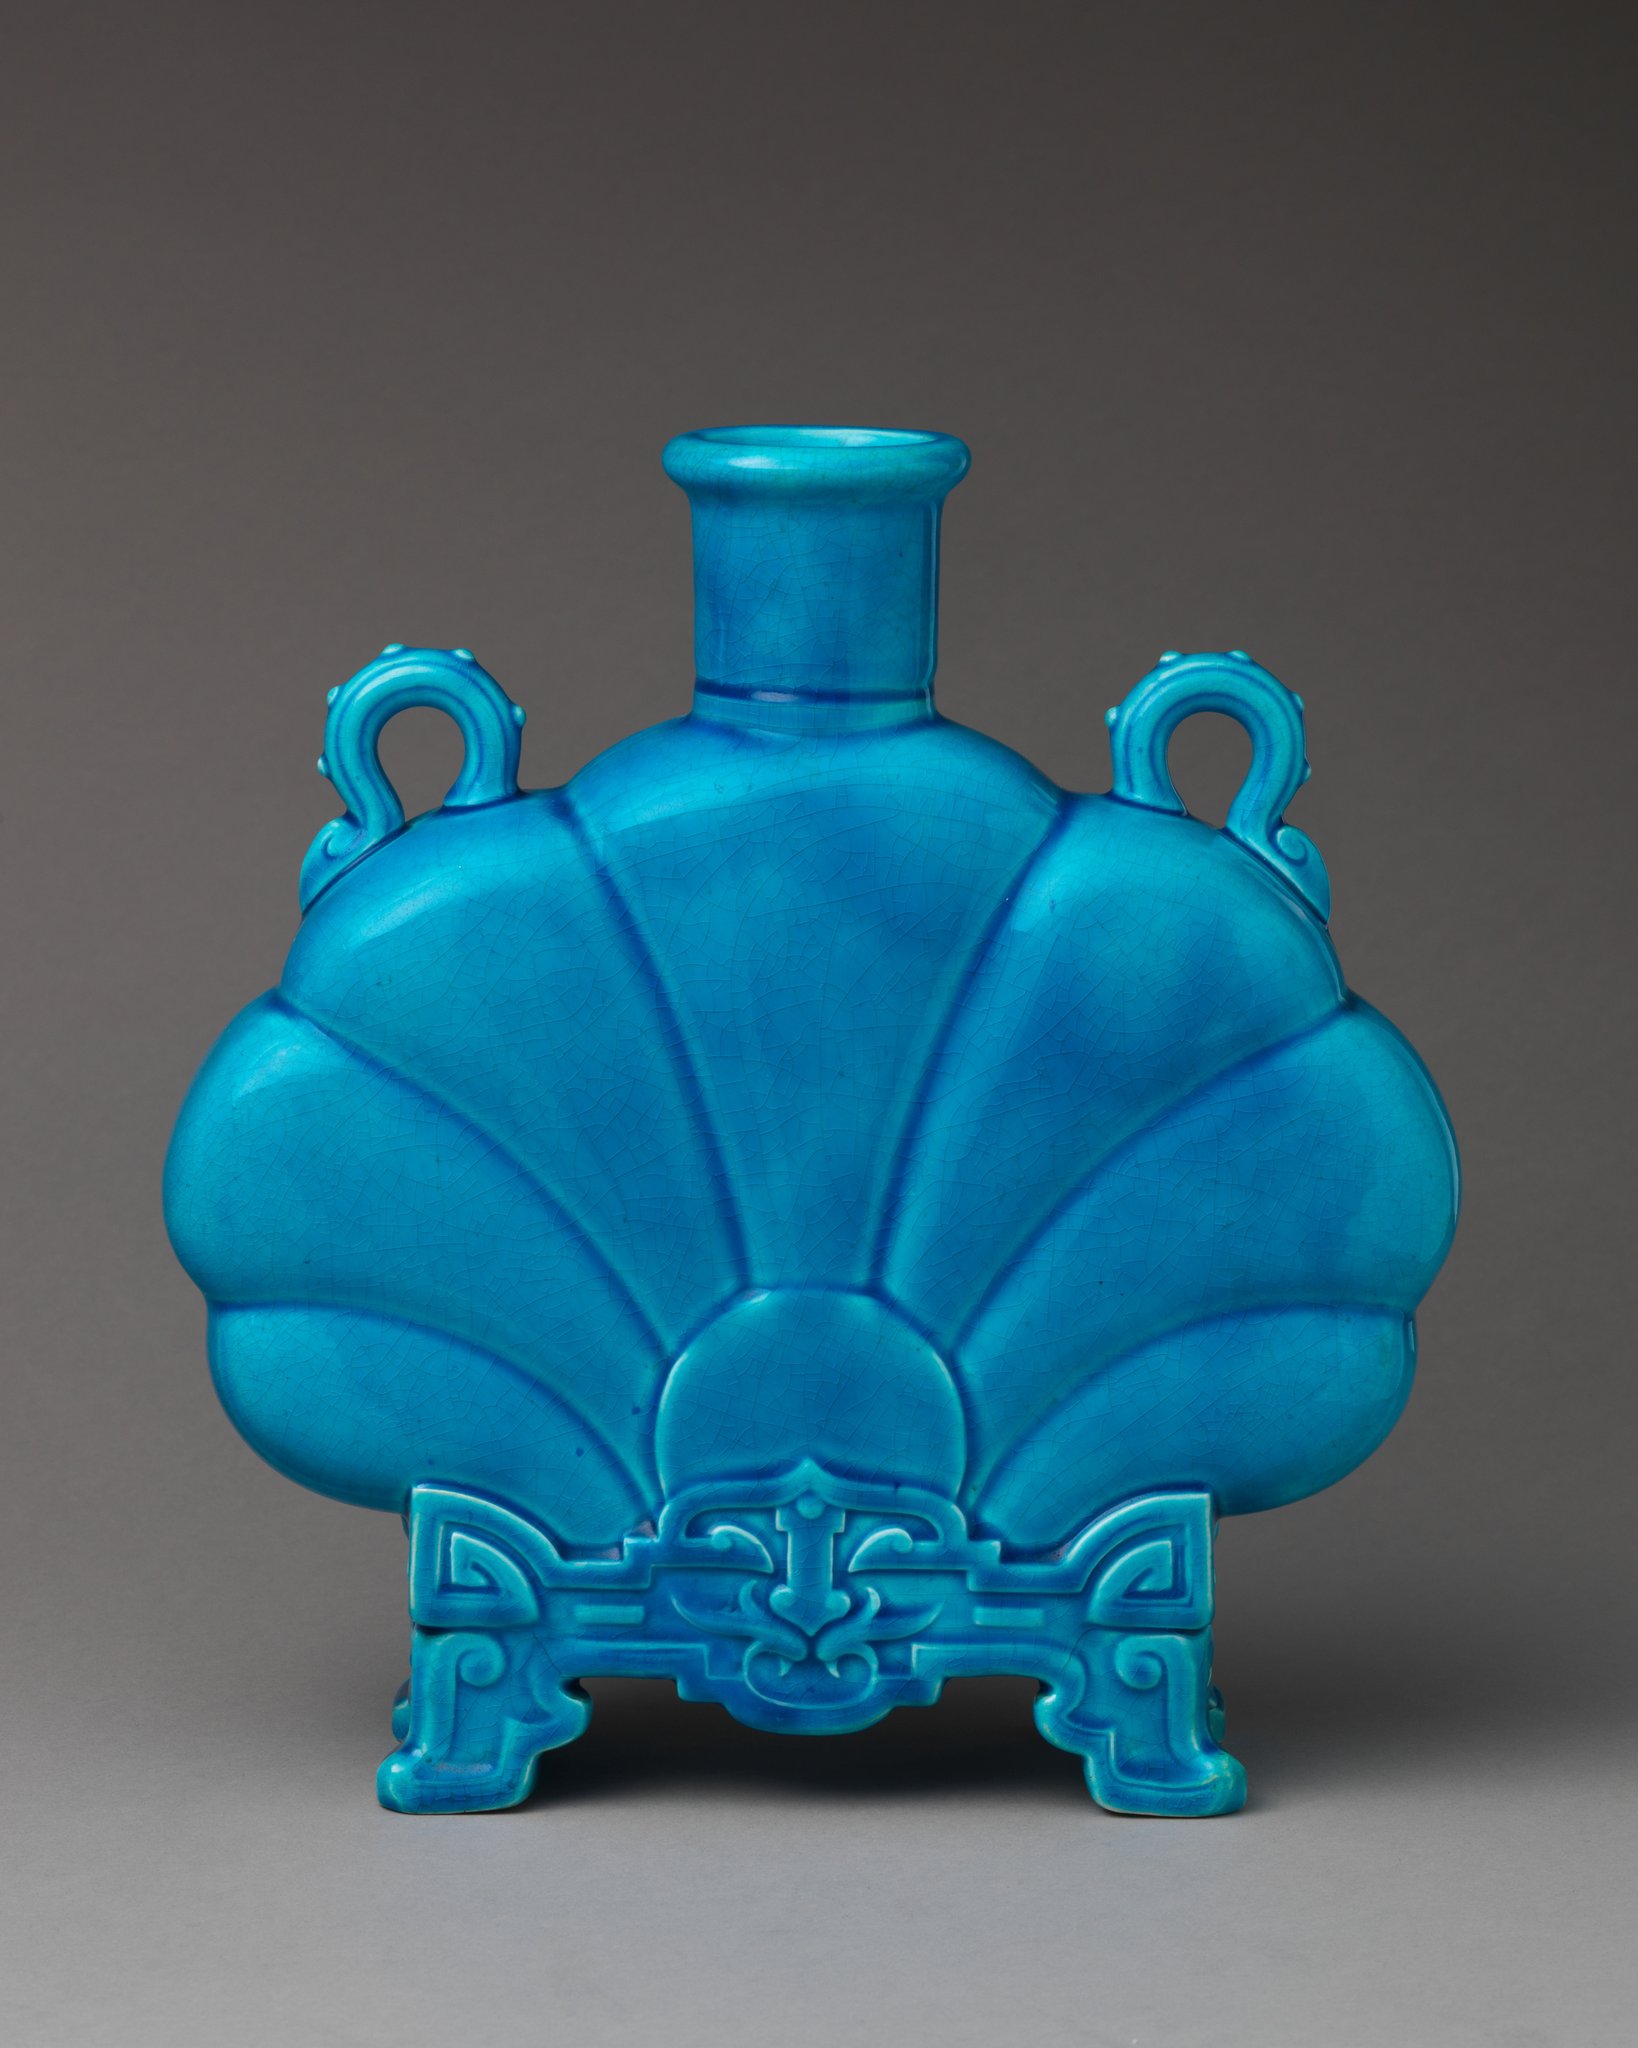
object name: bottle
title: Fan-shape 'Persian' bottle with handles (one of a pair)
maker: minton(s)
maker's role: maker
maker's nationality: british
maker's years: 1793-2001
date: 1870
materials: earthenware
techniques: glazing